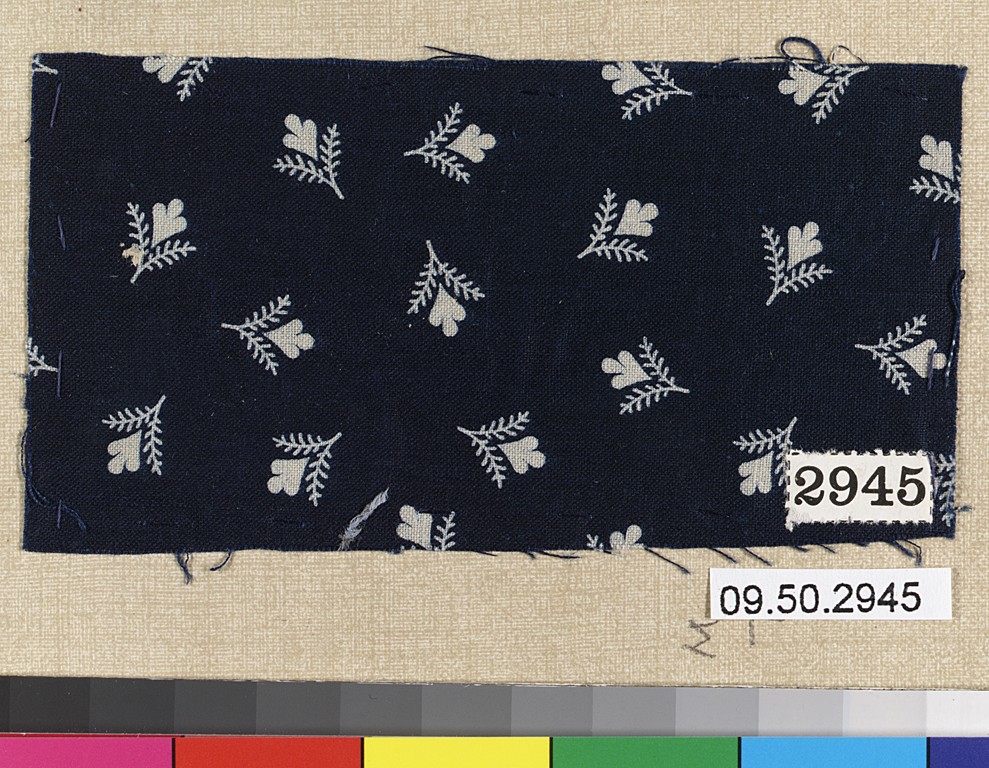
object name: piece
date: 1801-1900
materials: cotton